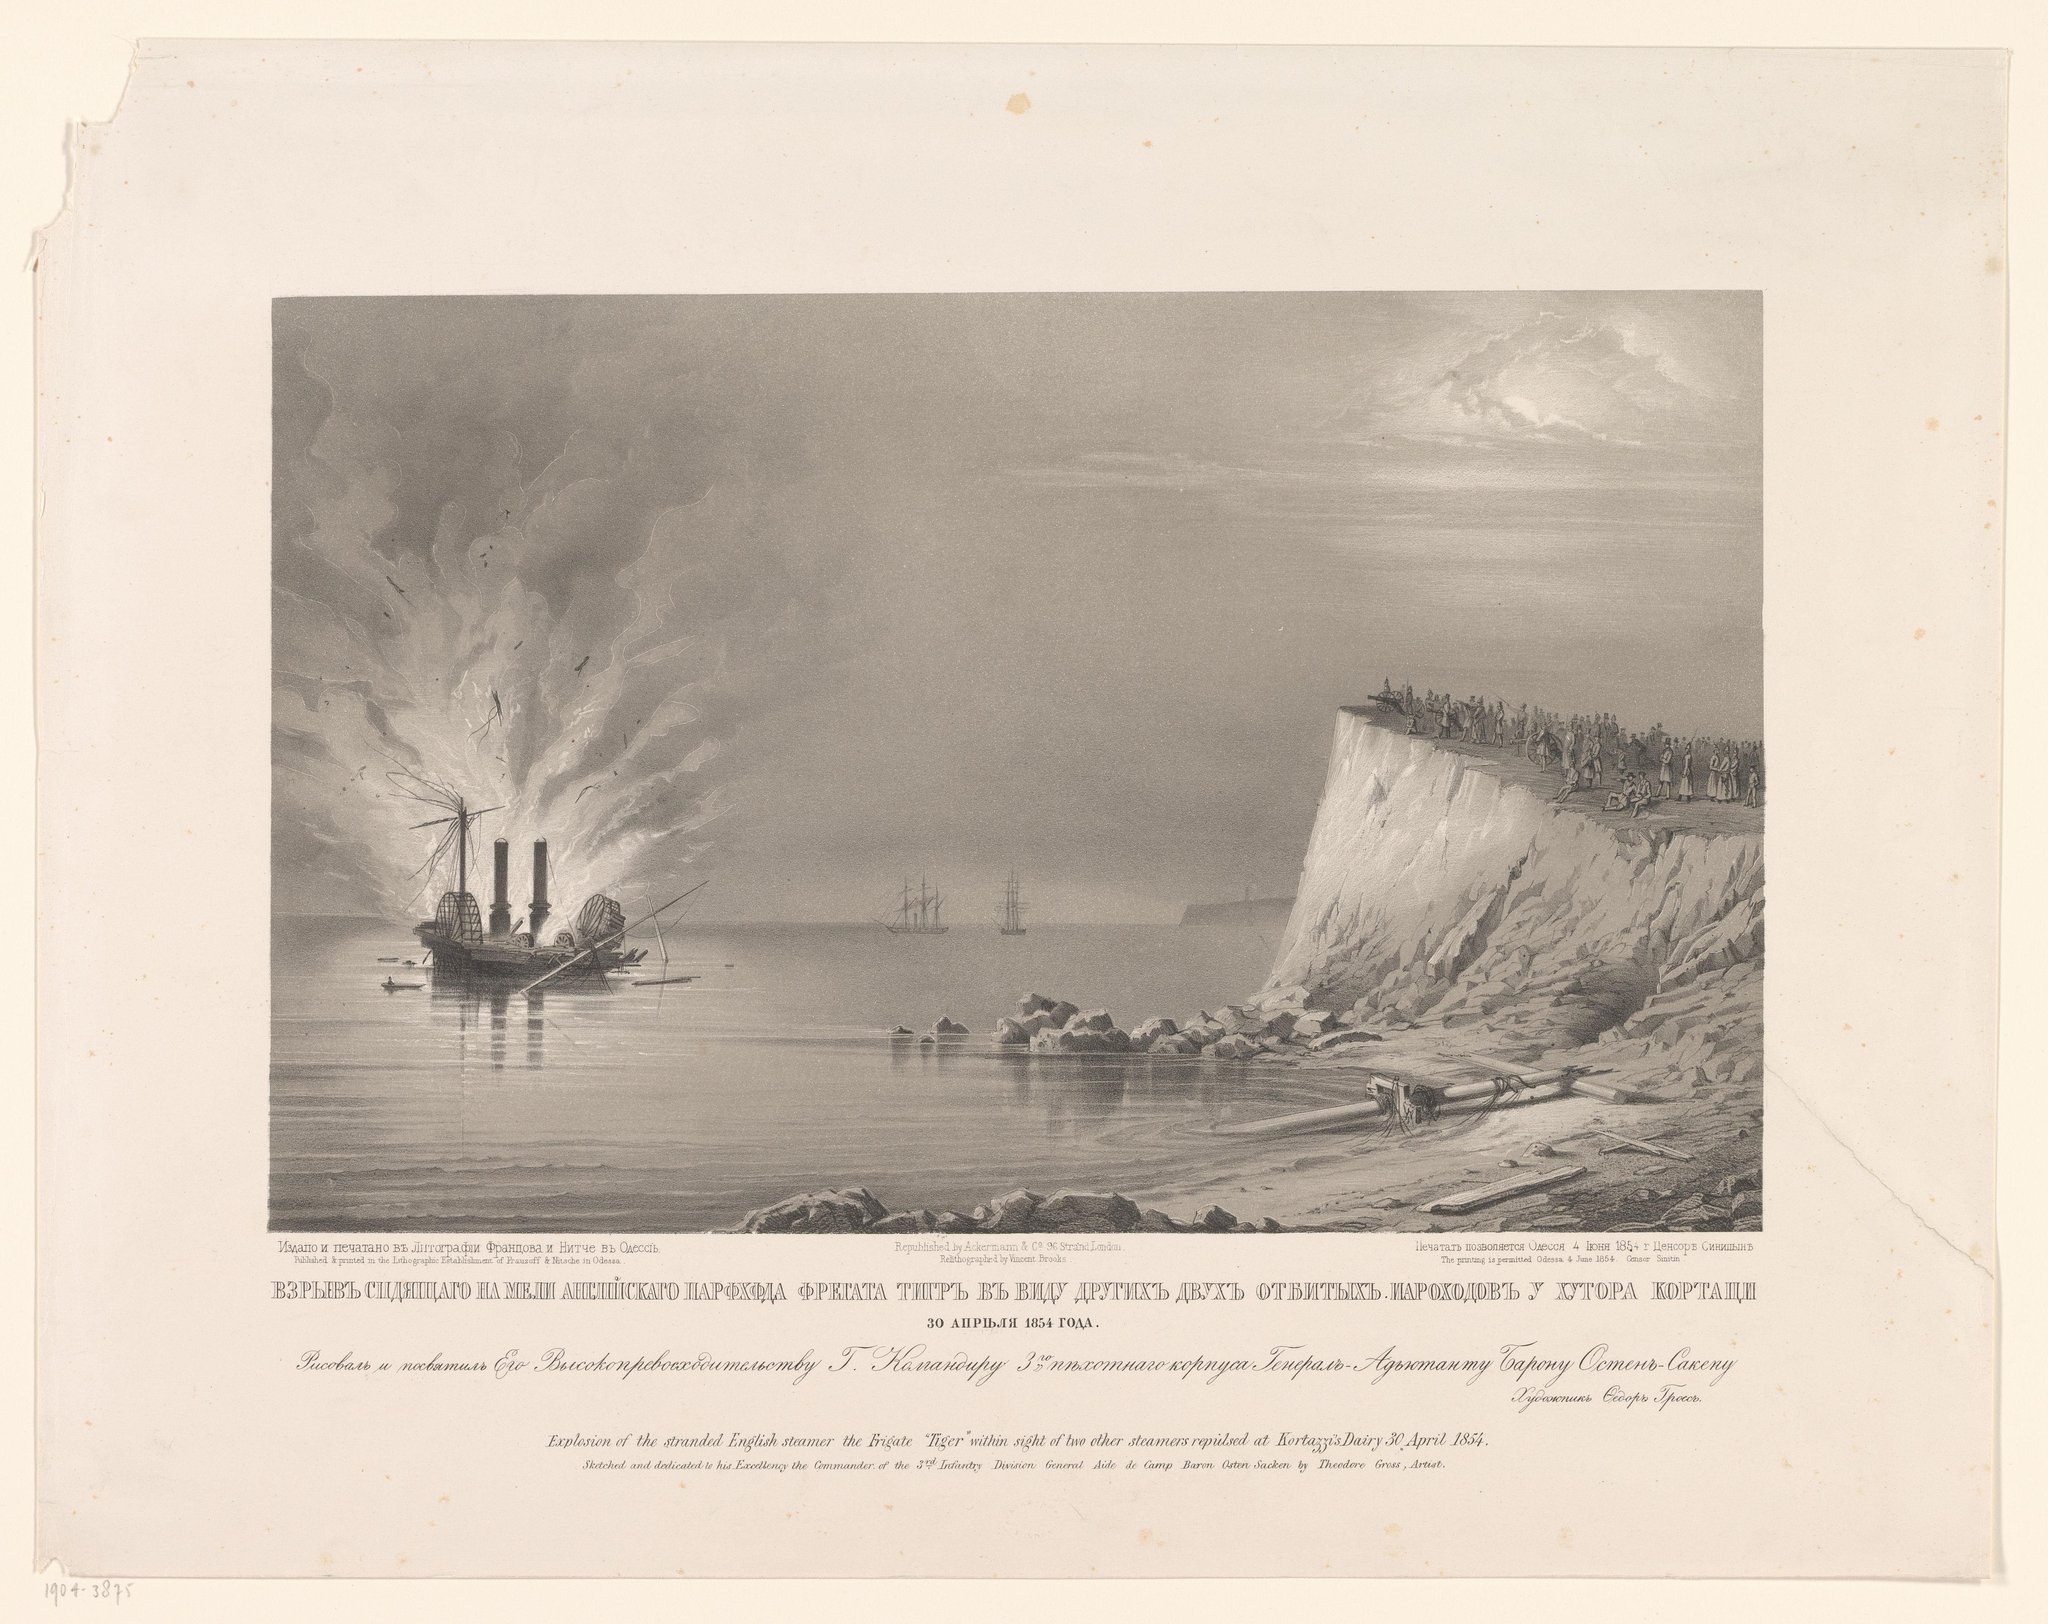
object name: print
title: Aanval op een schip langs de kust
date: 1854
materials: paper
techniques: lithograph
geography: london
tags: firearms: cannon, traffic on the water, coast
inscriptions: collector's mark: Lugt 2228, check stamp: ‘Ackermann&co London’